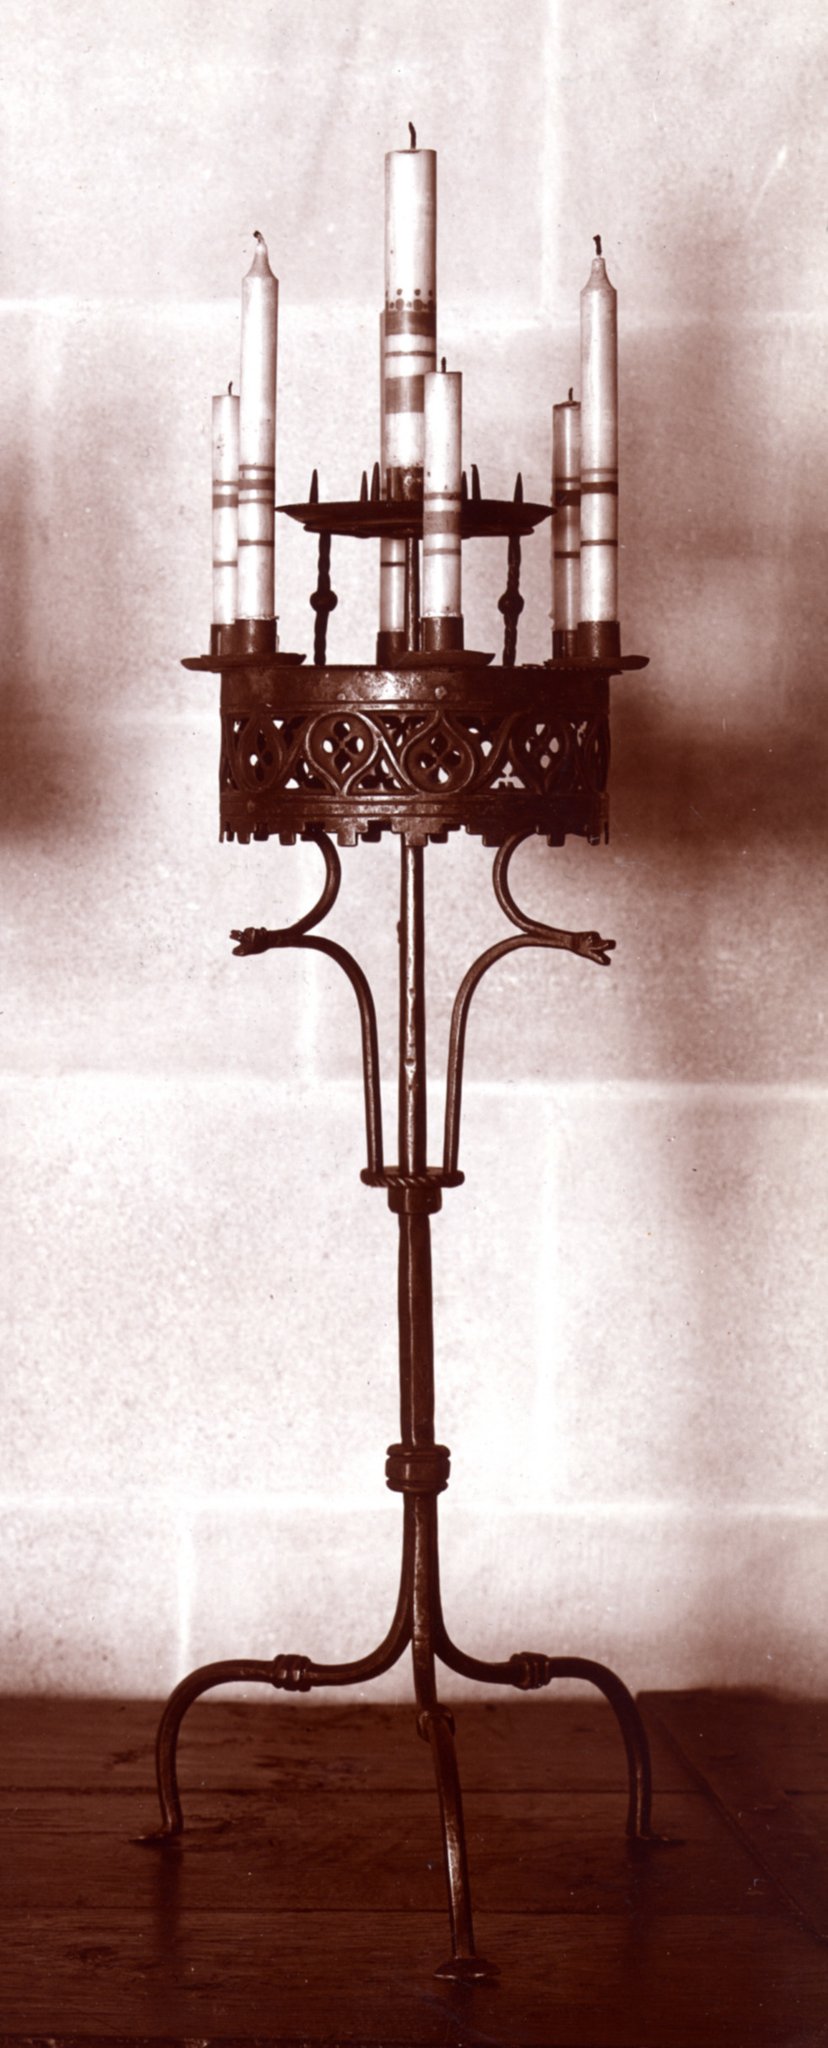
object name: candelabrum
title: Candelabra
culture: european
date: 1401-1500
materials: iron